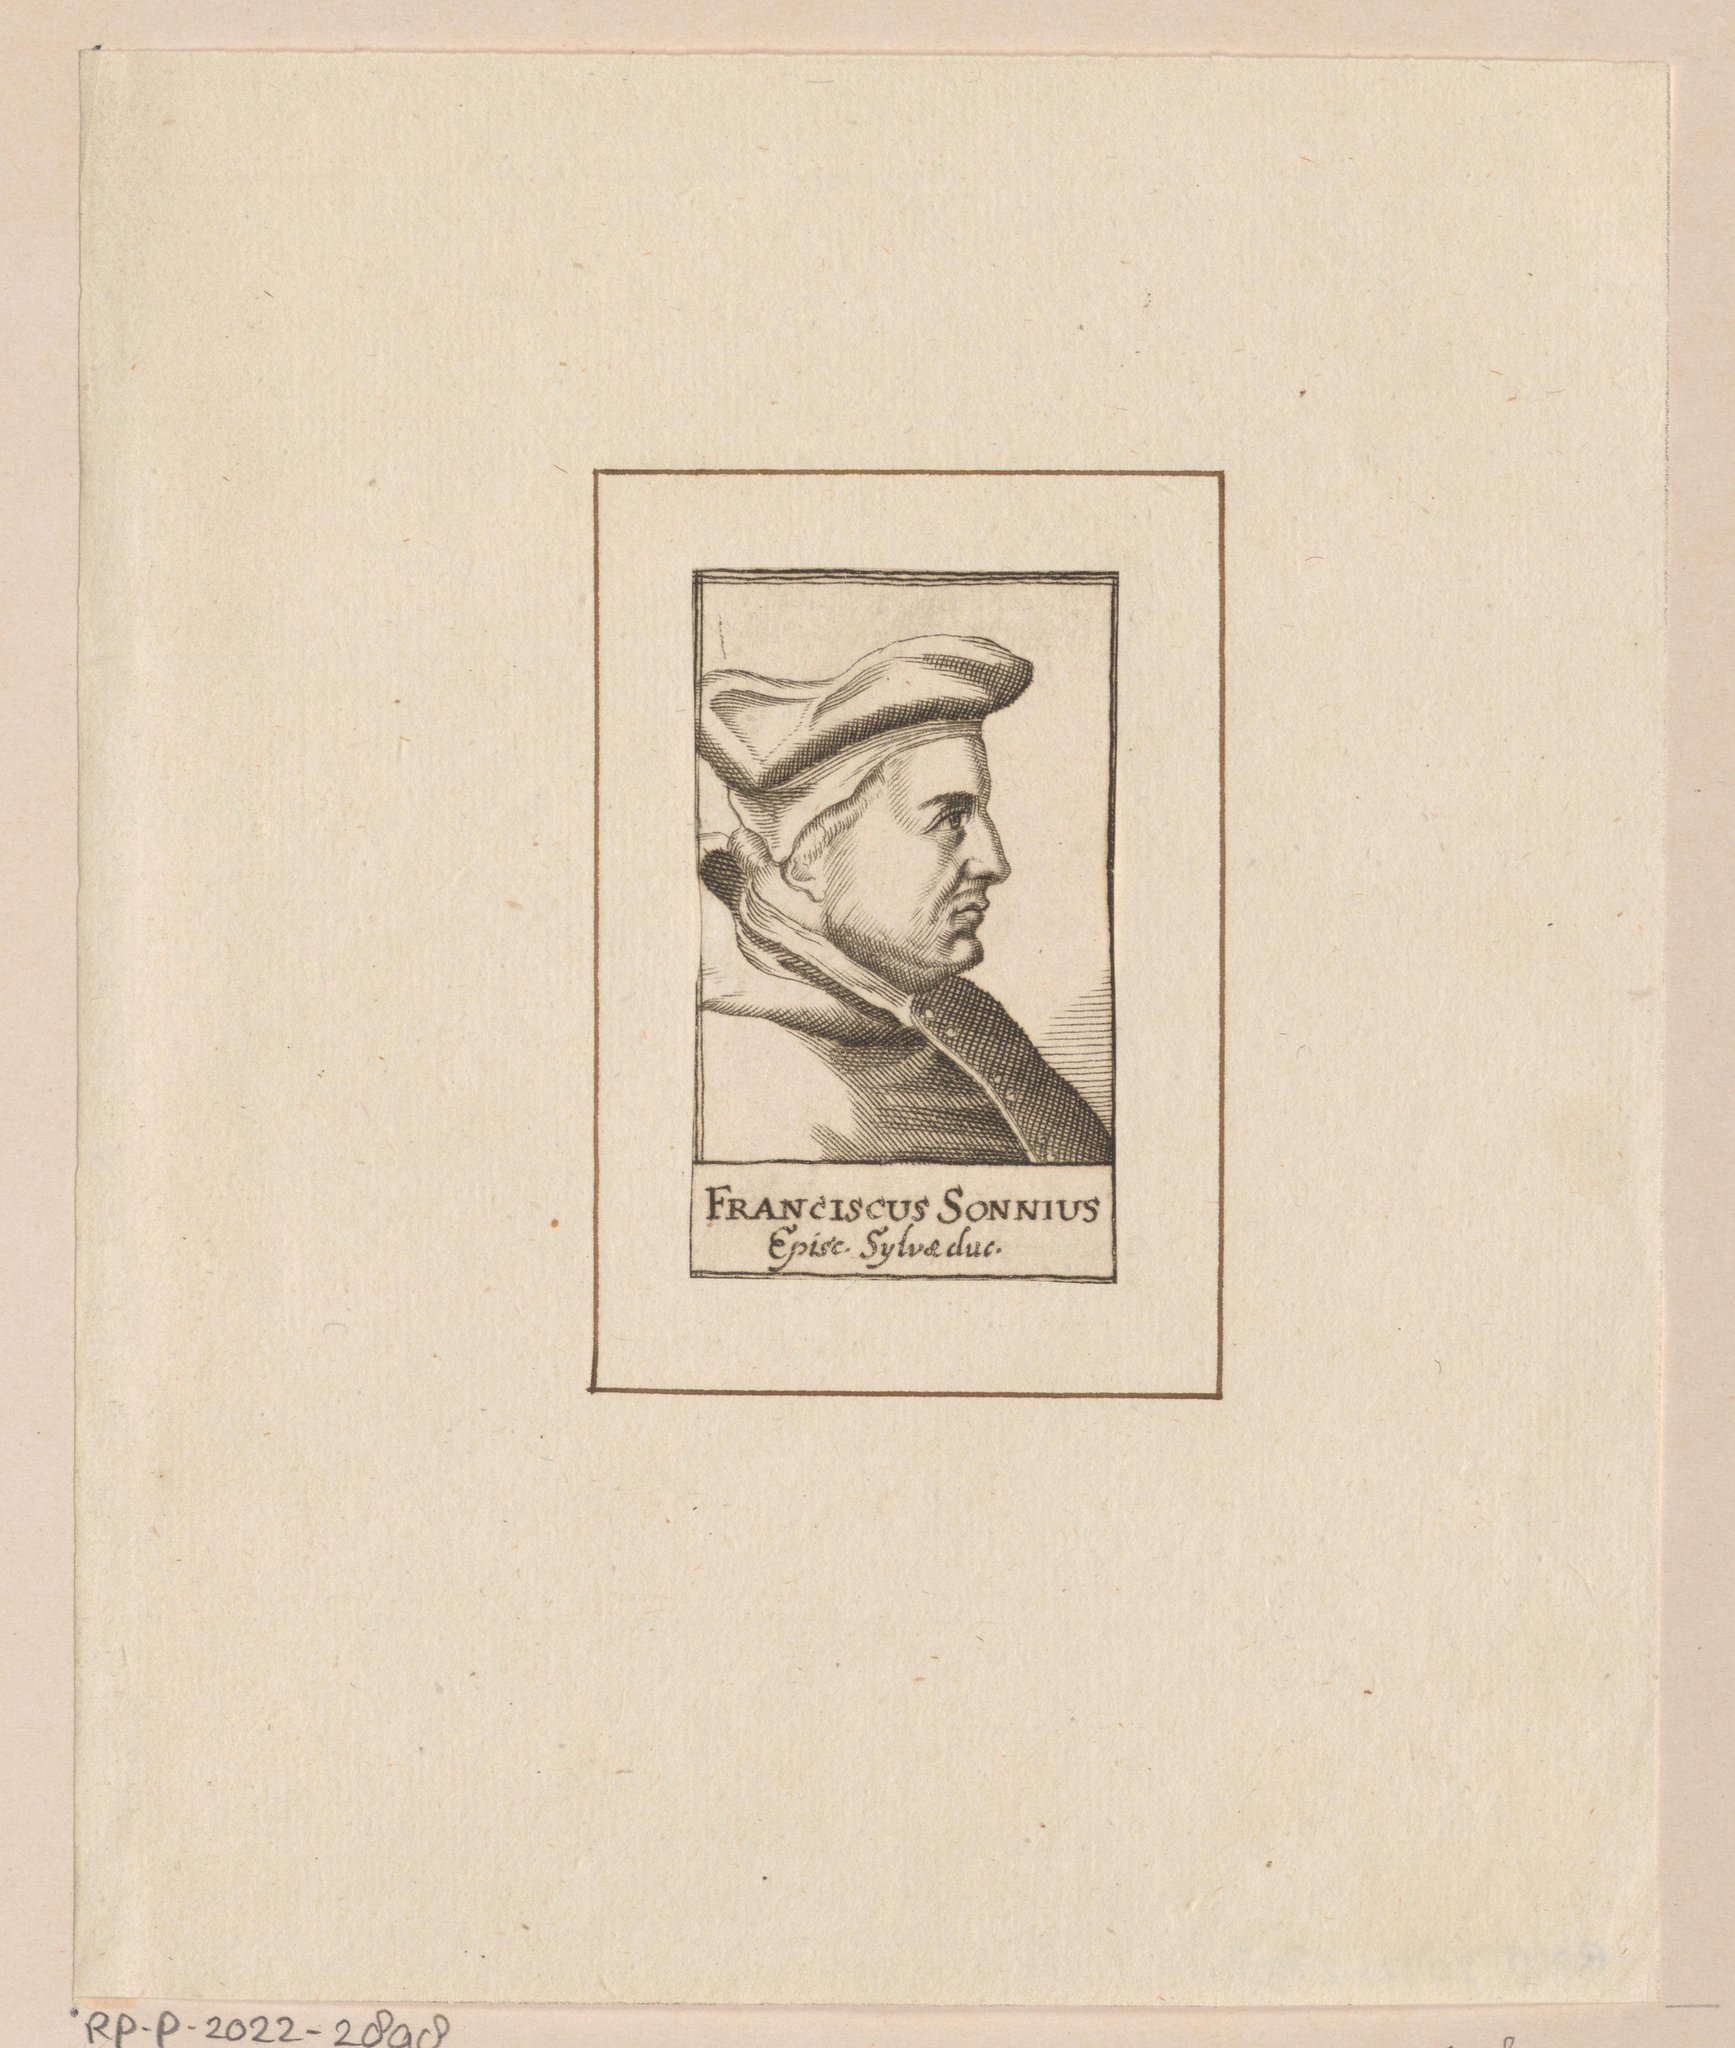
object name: print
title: Portret van Franciscus Sonnius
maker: Anonymous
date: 1688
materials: ink, paper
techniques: engraving, pen, snipping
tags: archbishop, bishop, etc. (roman catholic), theologian, historical persons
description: Prent uit: Freher, Paul. Theatrum virorum eruditione clarorum. Neurenberg: Johann Hoffmann, 1688.